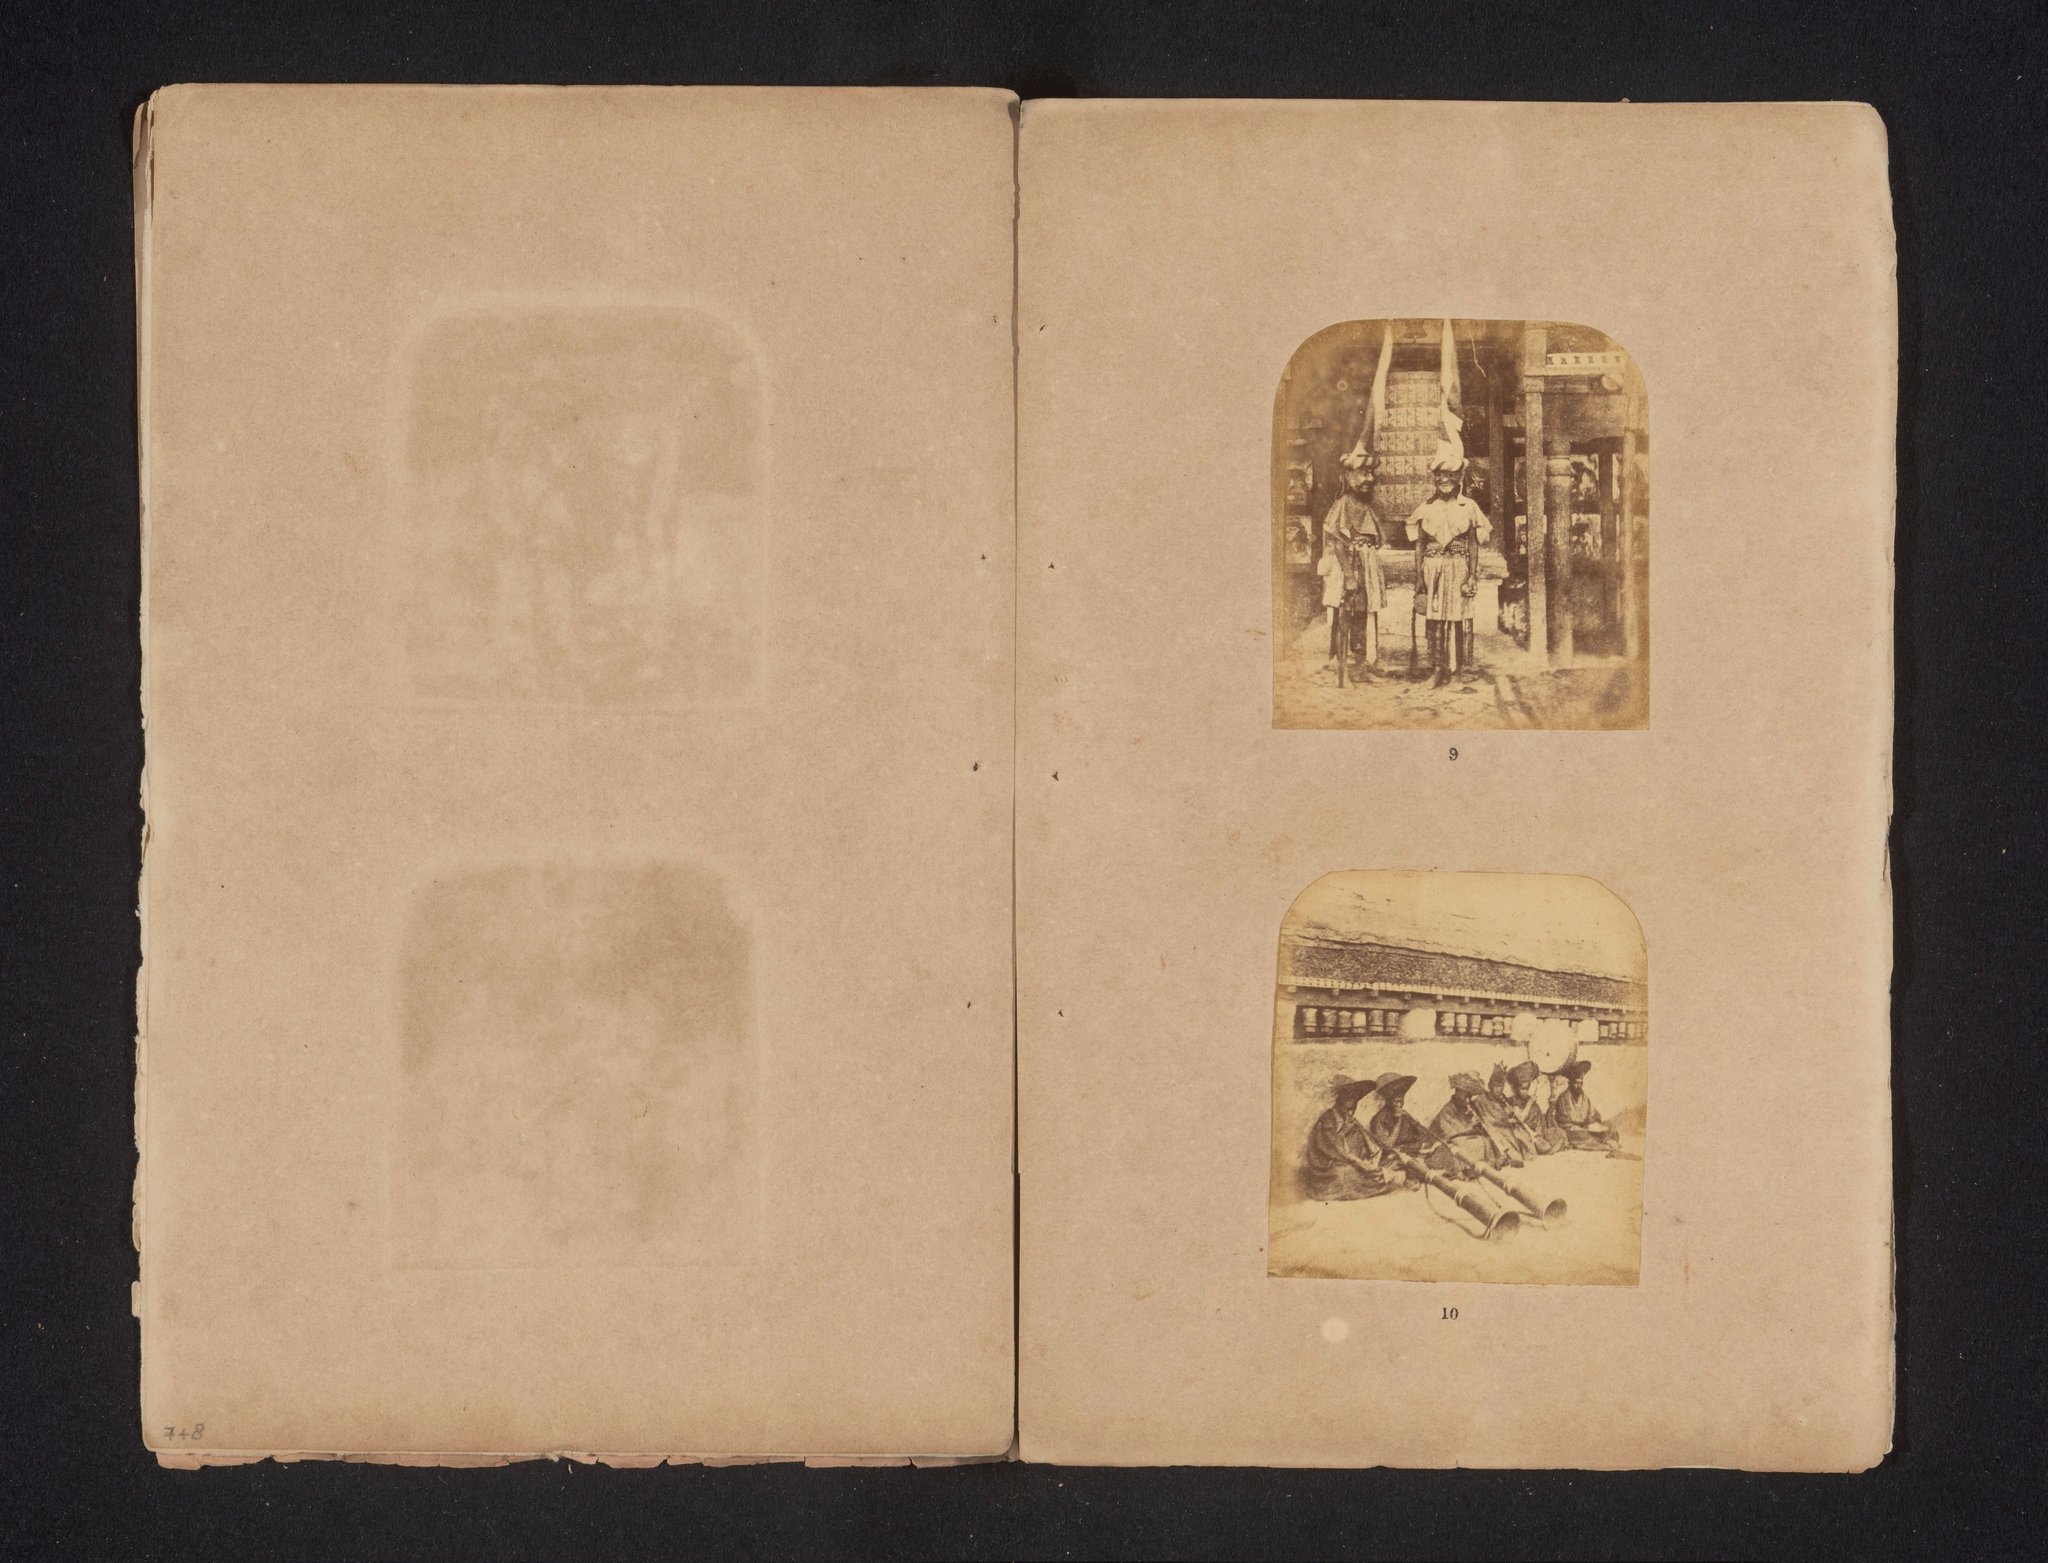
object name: photograph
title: Twee acteurs met maskers uit een toneelstuk in India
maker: melville clark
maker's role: engineer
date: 1860-1865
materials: photographic support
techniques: albumen print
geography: india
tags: mask, portrait of actor, actress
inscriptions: number: ‘9’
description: Foto op negende ongenummerde pagina na pagina 74. Foto is de helft van een stereofoto.